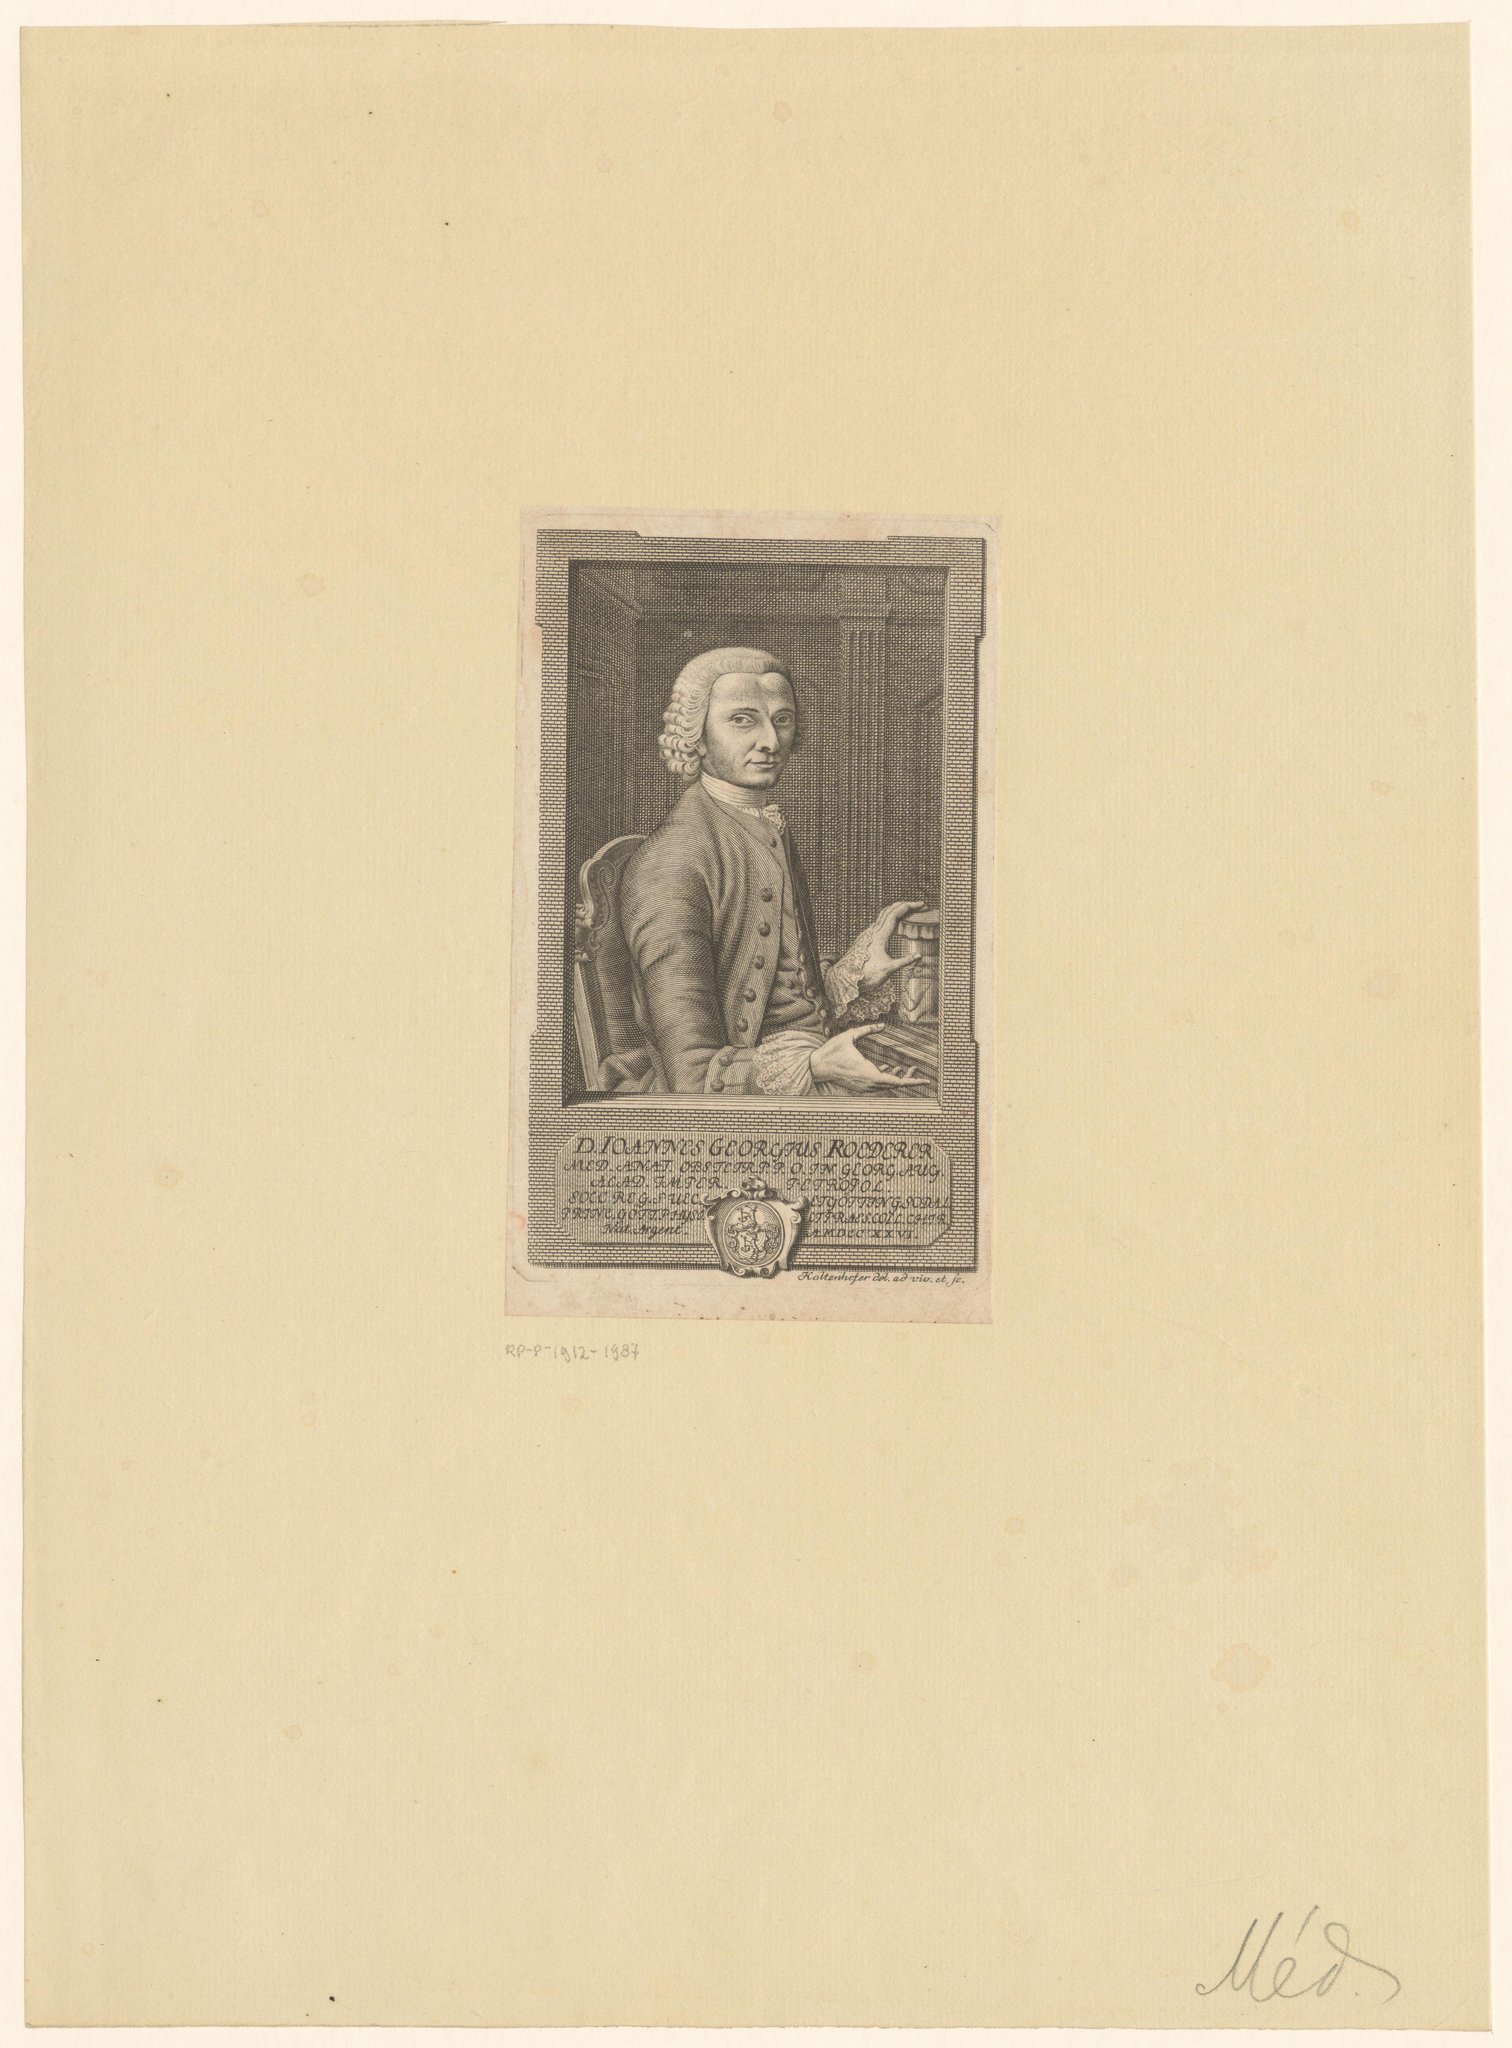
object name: print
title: Portret van Johann Georg Roederer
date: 1759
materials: paper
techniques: engraving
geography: gottingen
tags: historical persons, physician, doctor (+ portrait of scholar, scientist)